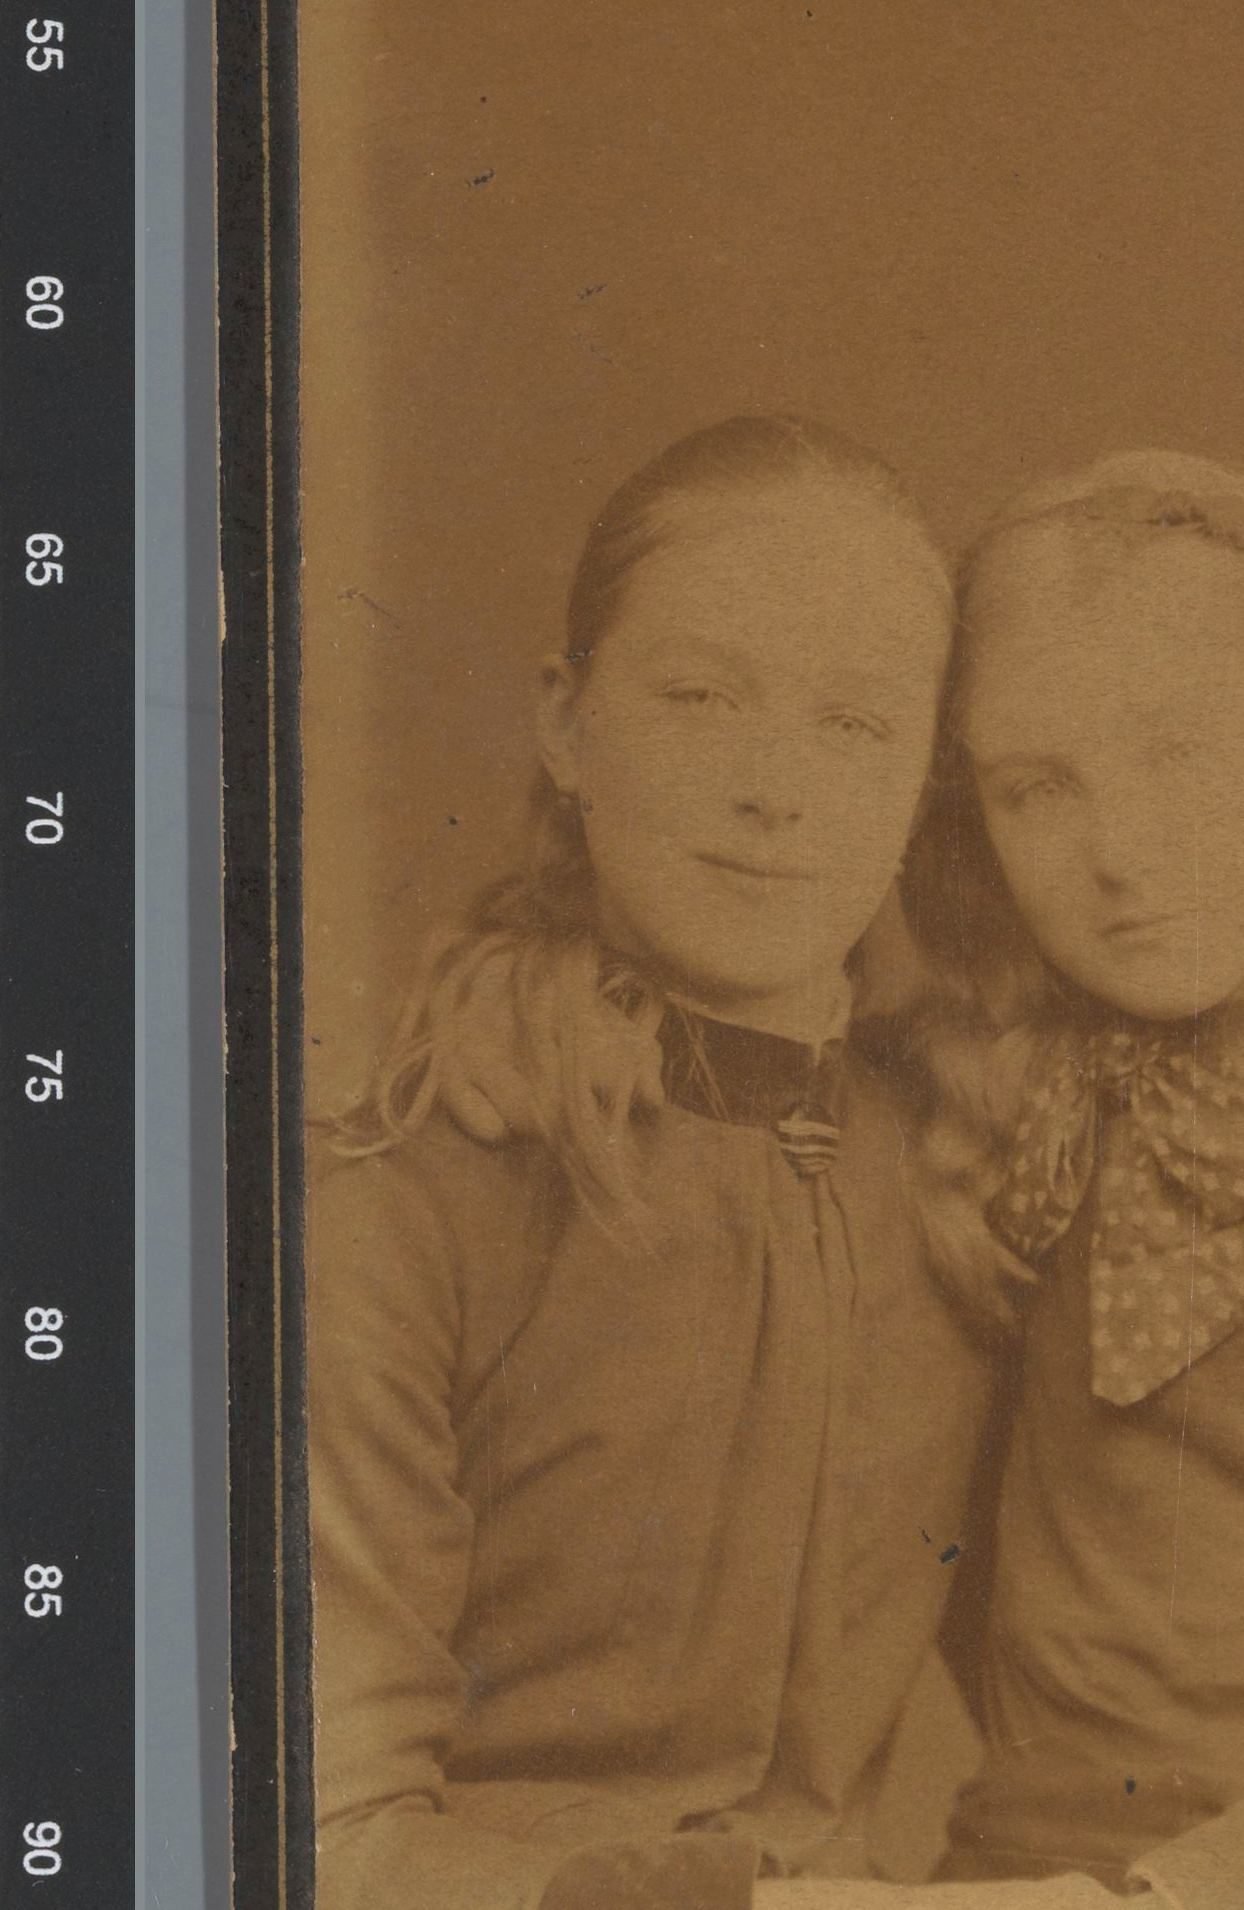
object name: photograph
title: Portret van twee onbekende meisjes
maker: george lodewijk mulder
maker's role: fotograaf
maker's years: 1841-1920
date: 1859-1898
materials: cardboard, paper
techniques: albumen print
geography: utrecht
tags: girl (child between toddler and youth), anonymous historical person portrayed, utrecht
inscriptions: inscription: ‘G.L. Mulder/ Senatus Veteranorum/ Effigierum Opifex./ van Wijckskade H.326./ Utrecht.’, inscription: ‘G.L. Mulder Utrecht’